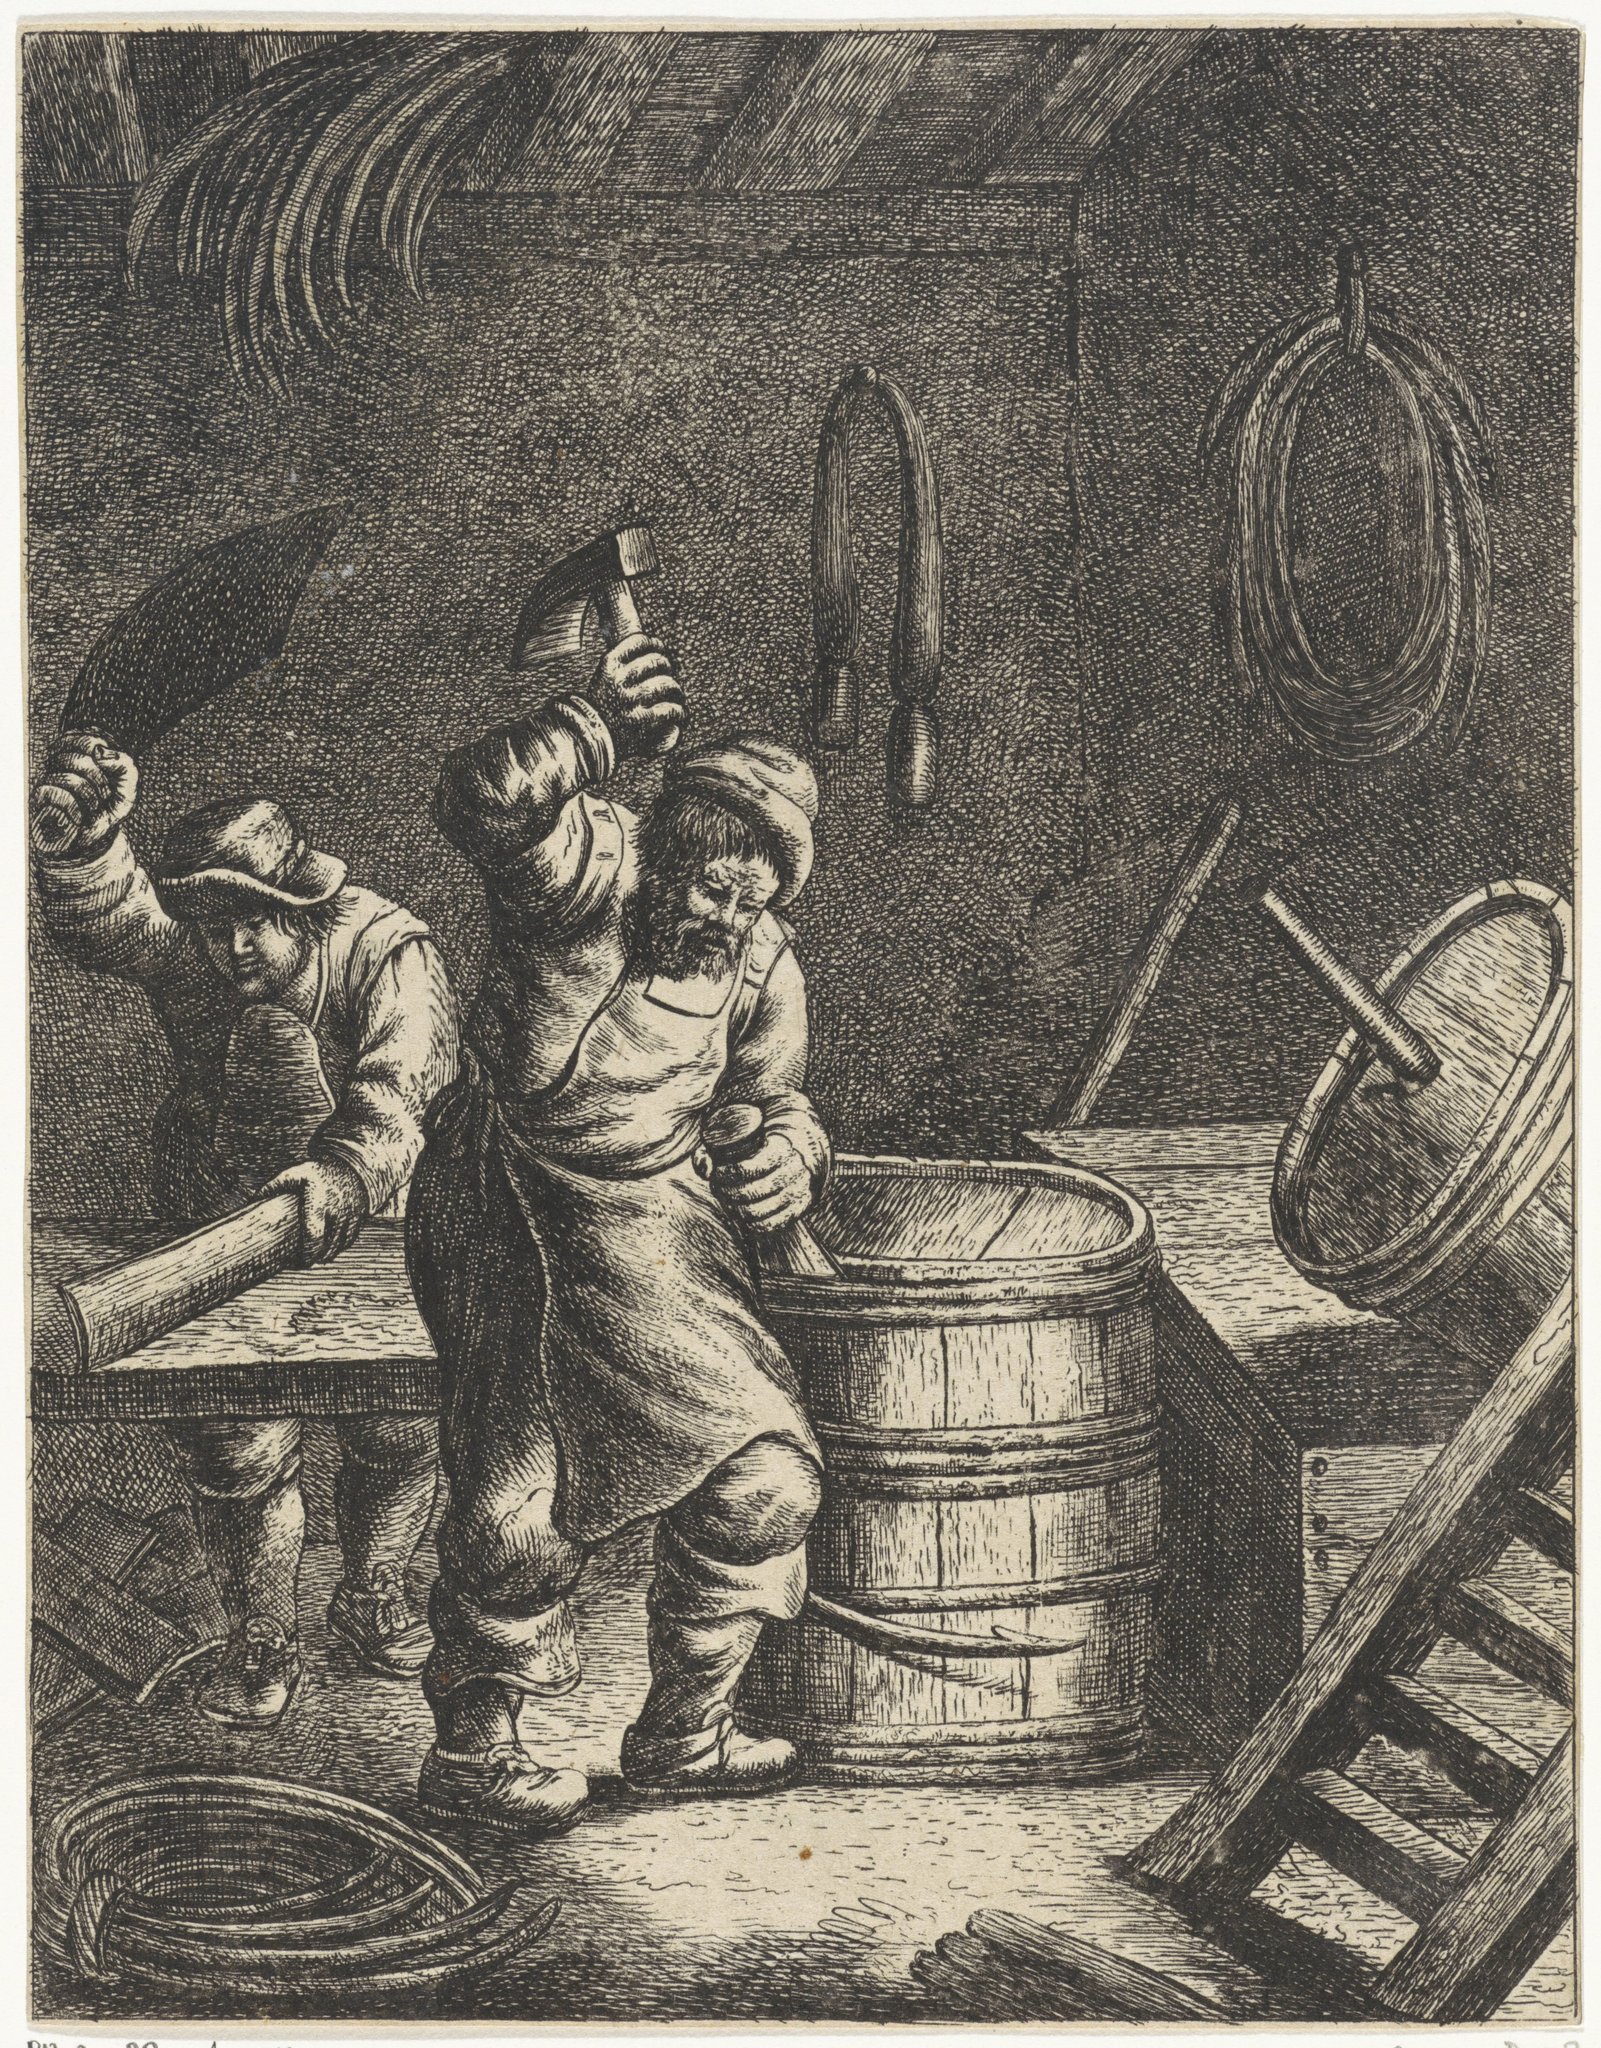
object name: print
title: Kuiper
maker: Anonymous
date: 1635-1685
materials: paper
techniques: engraving, etching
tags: craft-production, skilled handiwork, wooden container: barrel, cask, bucket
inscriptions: collector's mark, collector's mark: Lugt 1407, collector's mark: Lugt 2228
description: Kopie naar de prent uit de serie 'Beroepen' van Jan Gillisz. van Vliet.